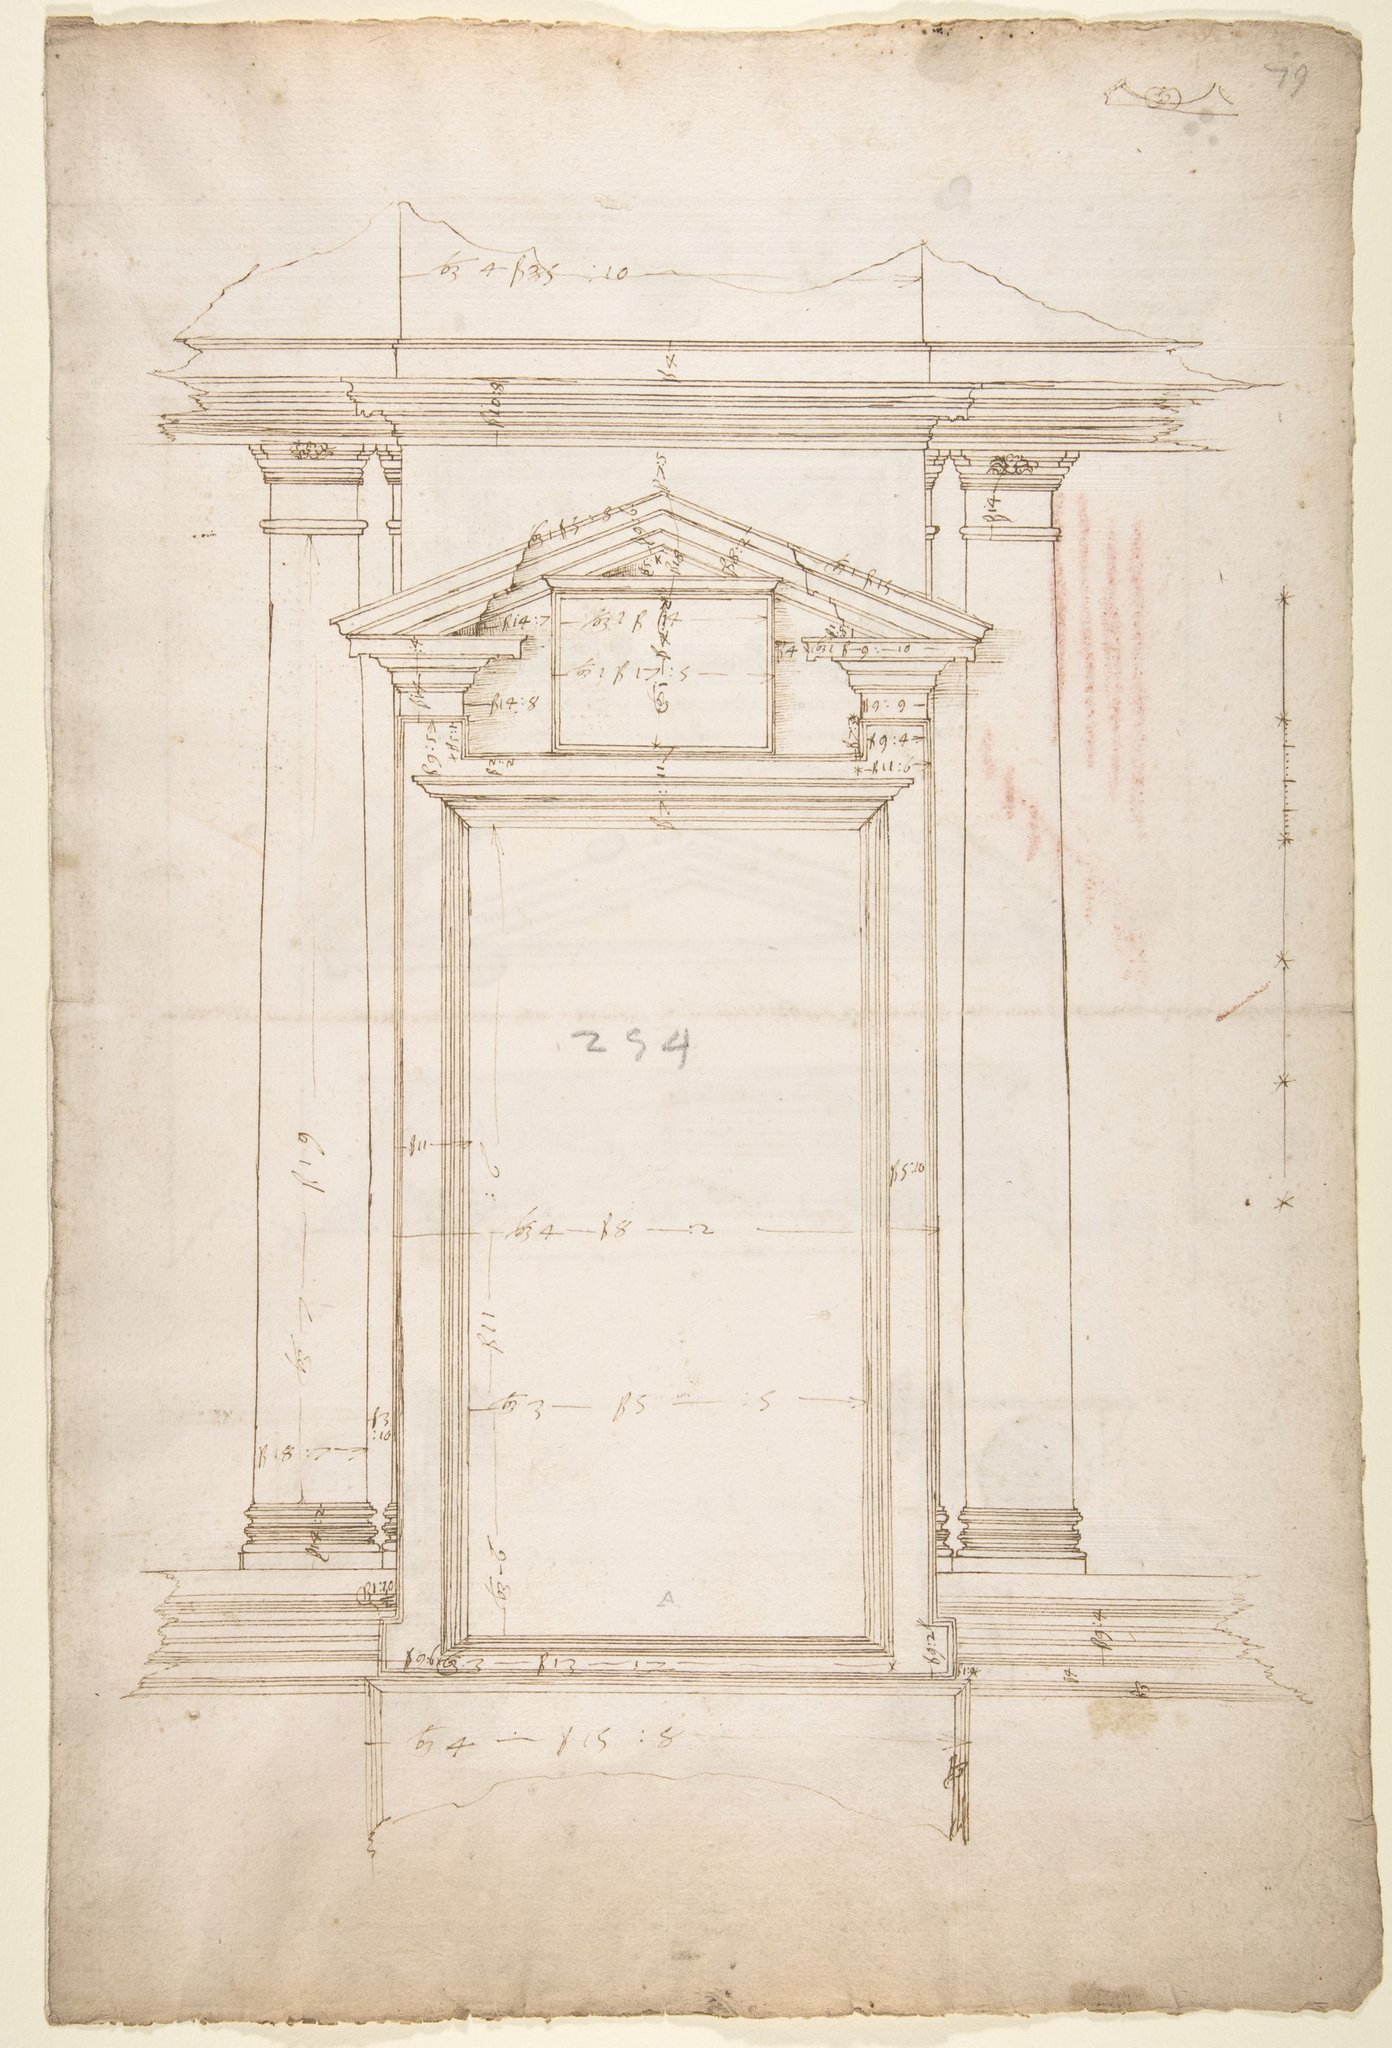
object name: drawing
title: San Lorenzo, Library, Ricetto, entry portal to library, elevation (recto) San Lorenzo, Library, Ricetto, entry portal to library, plan and wall detail (verso)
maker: anonymous, french, 16th century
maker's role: draftsman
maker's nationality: french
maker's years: 1500-1600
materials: chalk, ink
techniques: incising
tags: architecture